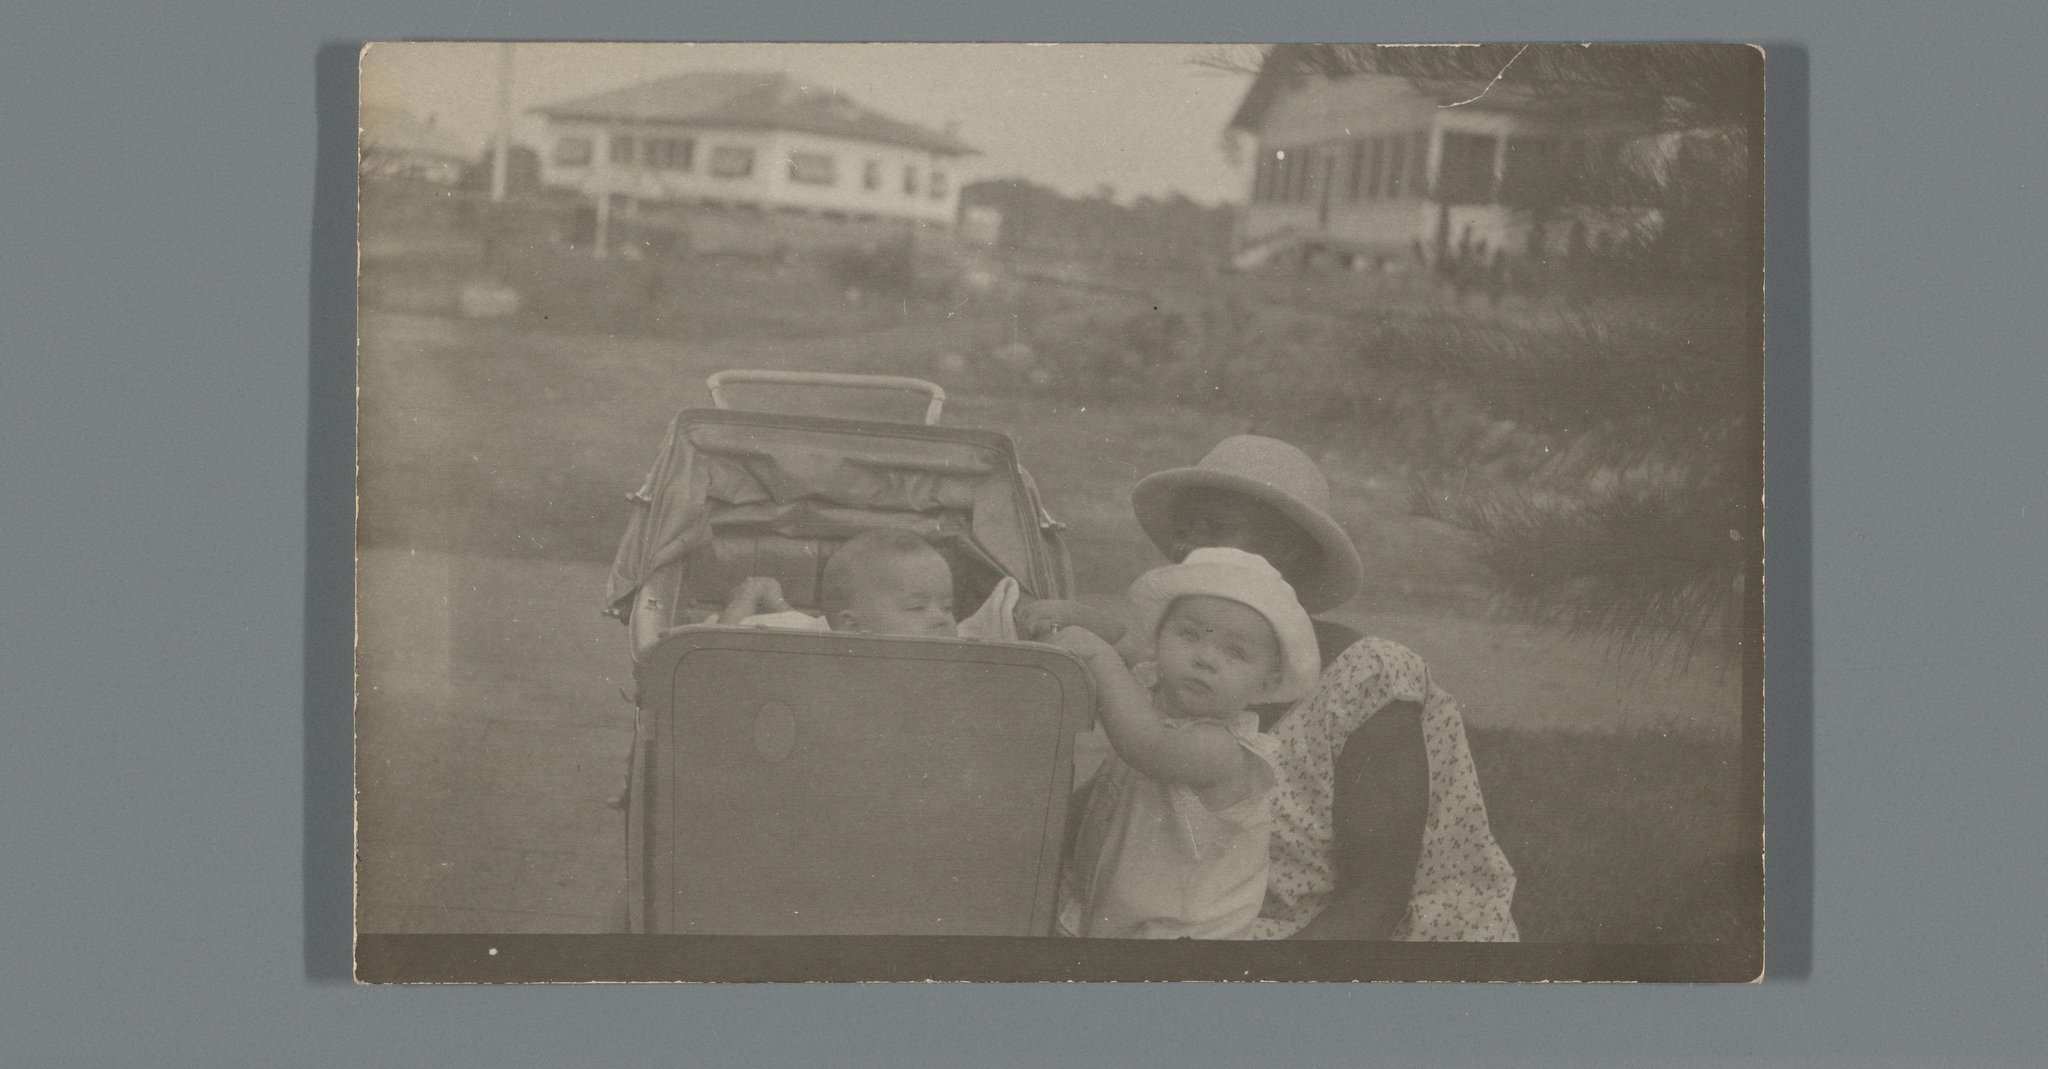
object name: photograph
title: Kinderverzorgster met kinderwagen en twee kindjes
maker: Anonymous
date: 1925-1927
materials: photographic support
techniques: photography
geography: suriname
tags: jetten, familie, moengo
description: Een Surinaamse kinderverzorgster met kinderwagen en twee kindjes. Onderdeel van het ensemble met foto's van de familie van ingenieur Jetten in de mijnbouwstad Moengo in Suriname.